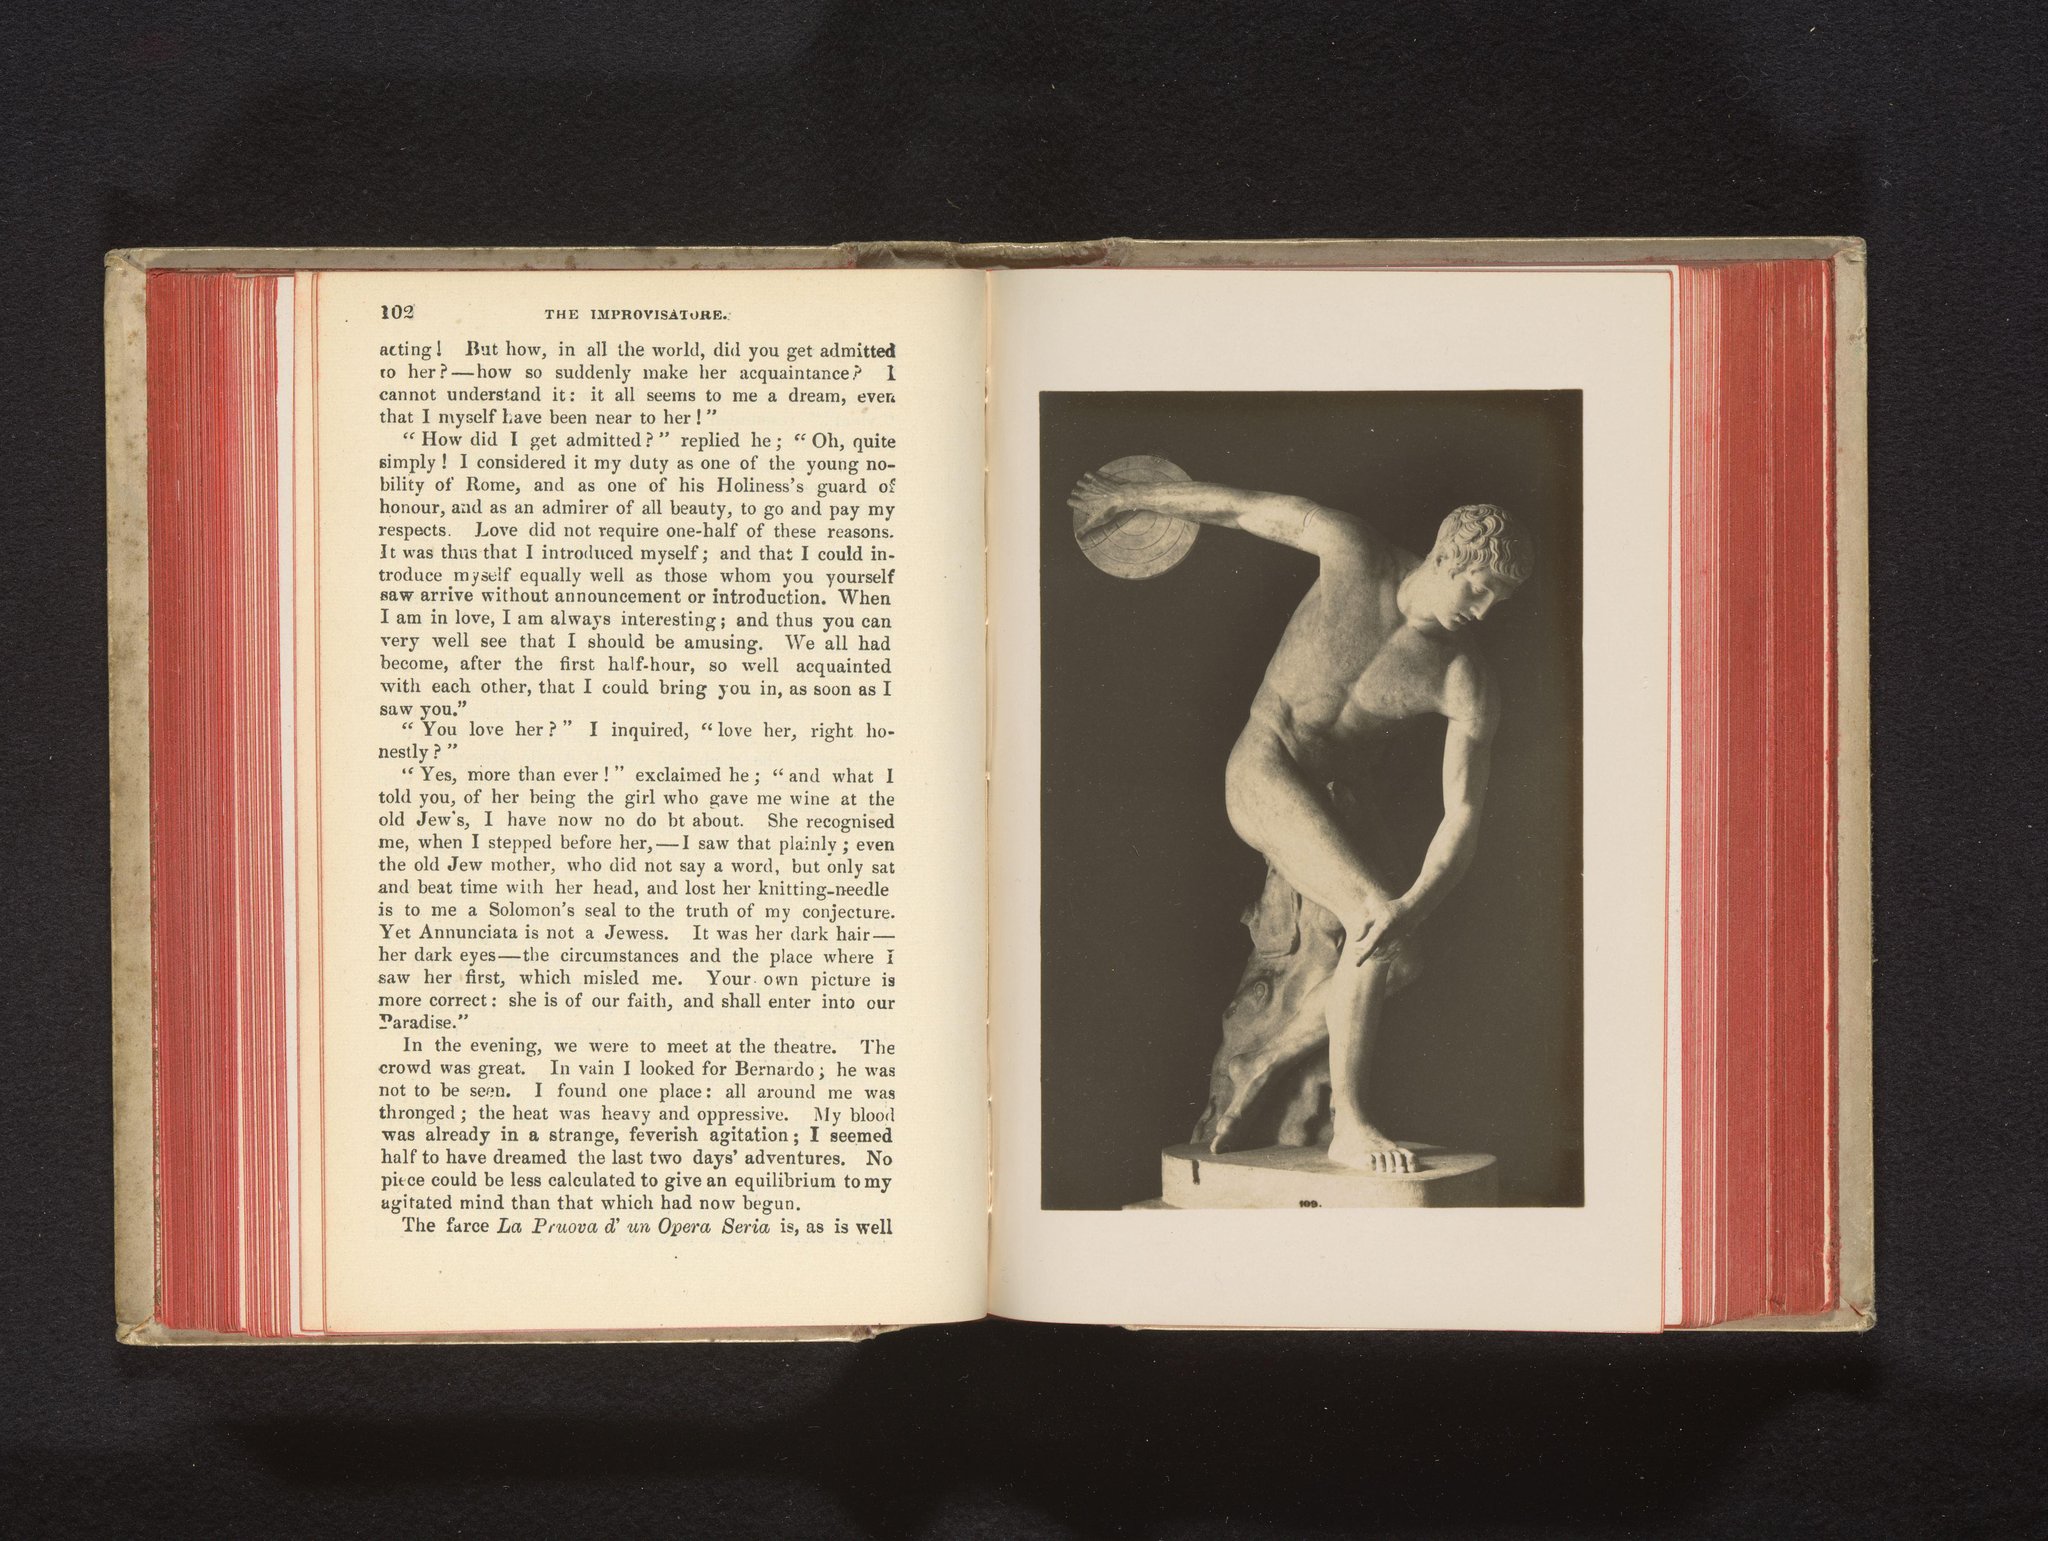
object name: page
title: Sculptuur van een discuswerper te Rome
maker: Anonymous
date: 1870-1880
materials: photographic support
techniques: gelatin silver print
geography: rome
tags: discus-throwing, sculpture